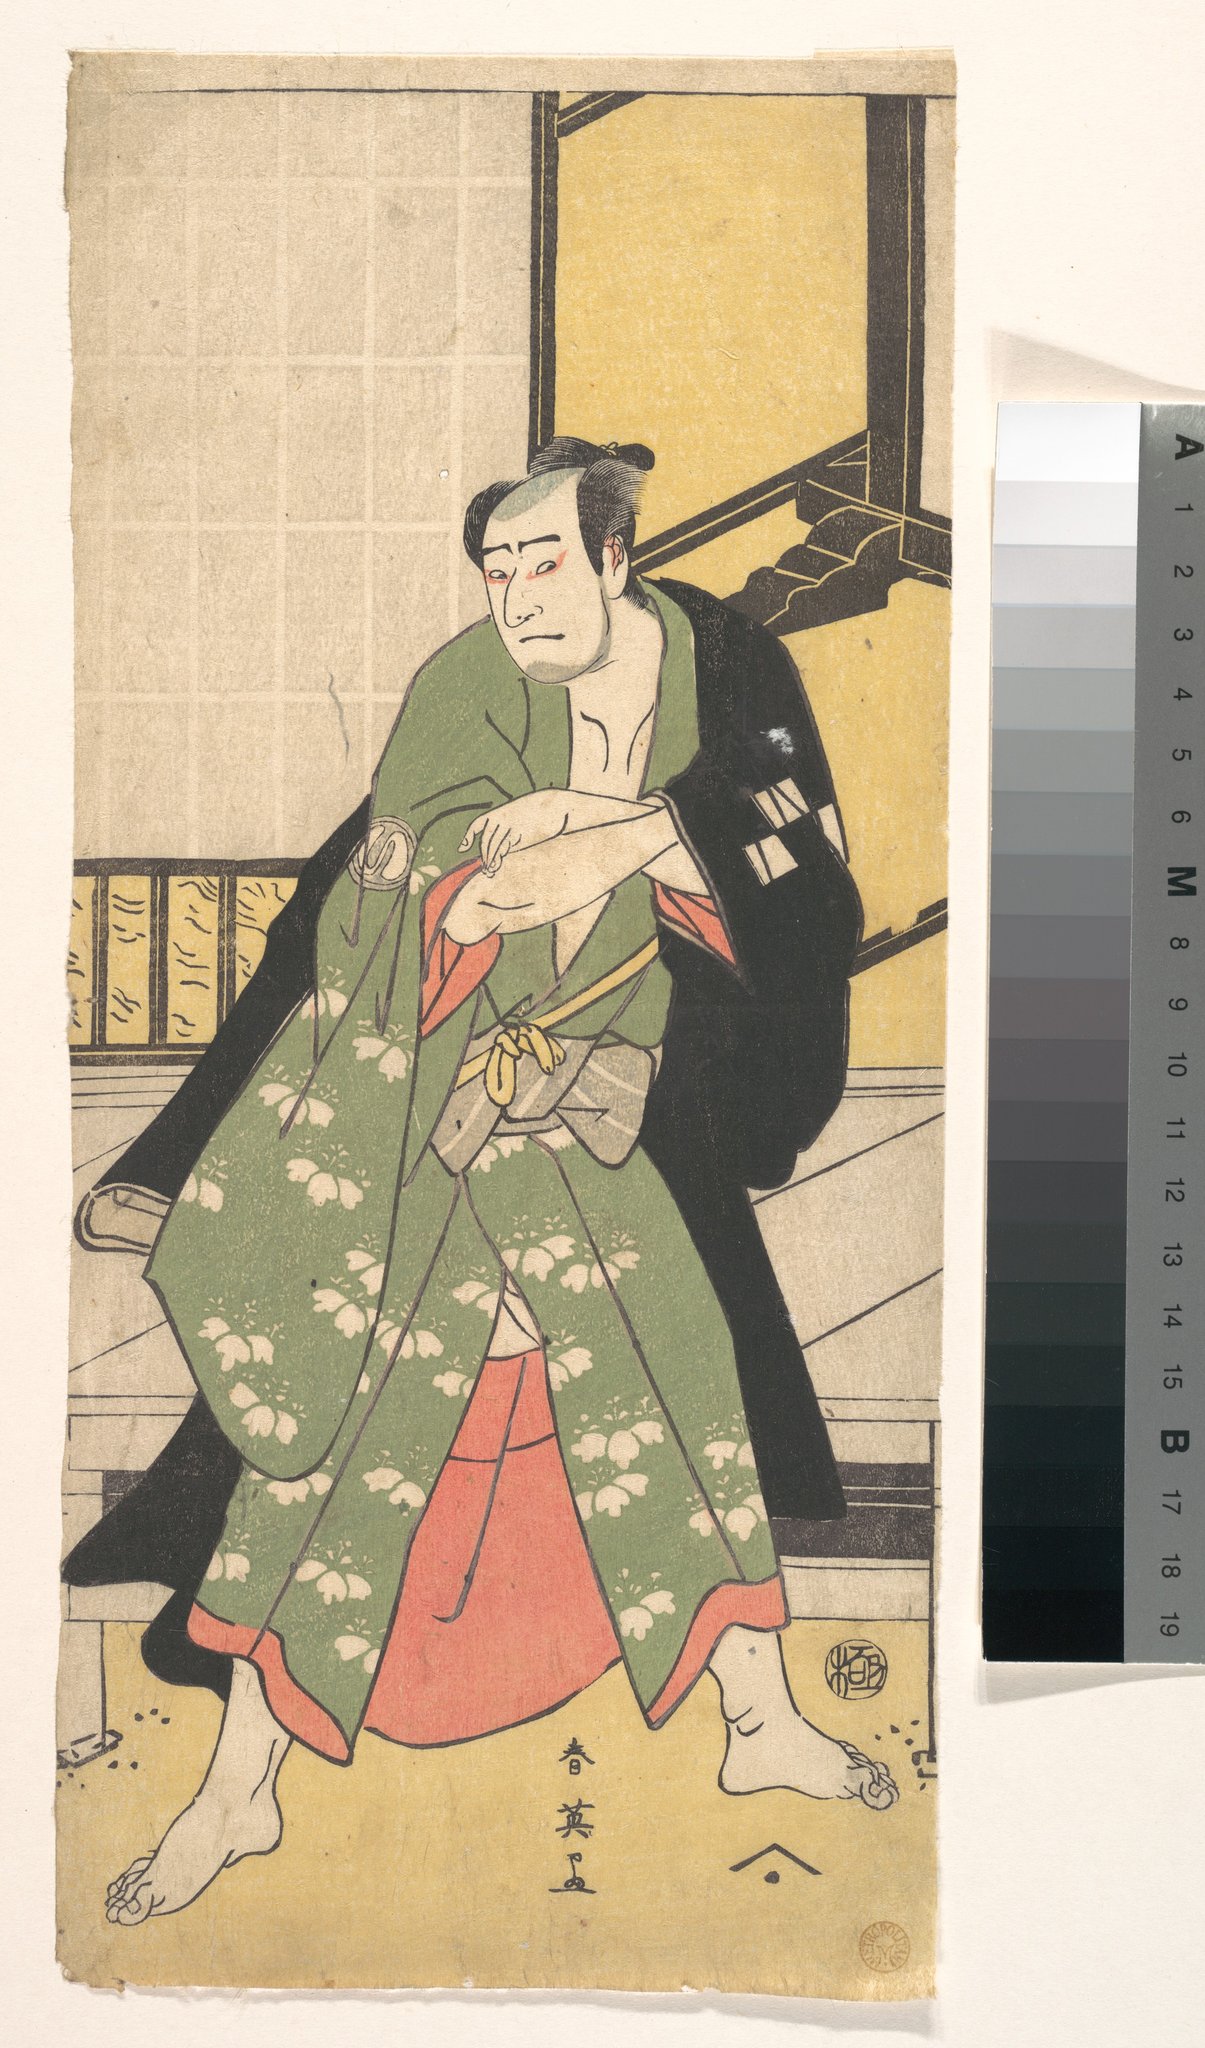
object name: print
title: The Third Sawamura Sojuro as a Man Standing with Feet Spread Widely Apart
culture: japanese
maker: katsukawa shun'ei 勝川春英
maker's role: artist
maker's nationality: japanese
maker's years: 1762-1819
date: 1795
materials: ink, paper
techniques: woodblock print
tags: men,actors